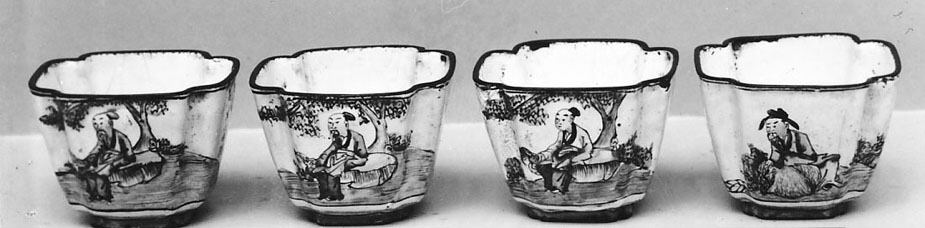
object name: cup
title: Square Cup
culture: chinese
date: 1736-1795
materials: enamel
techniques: painting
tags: men,trees